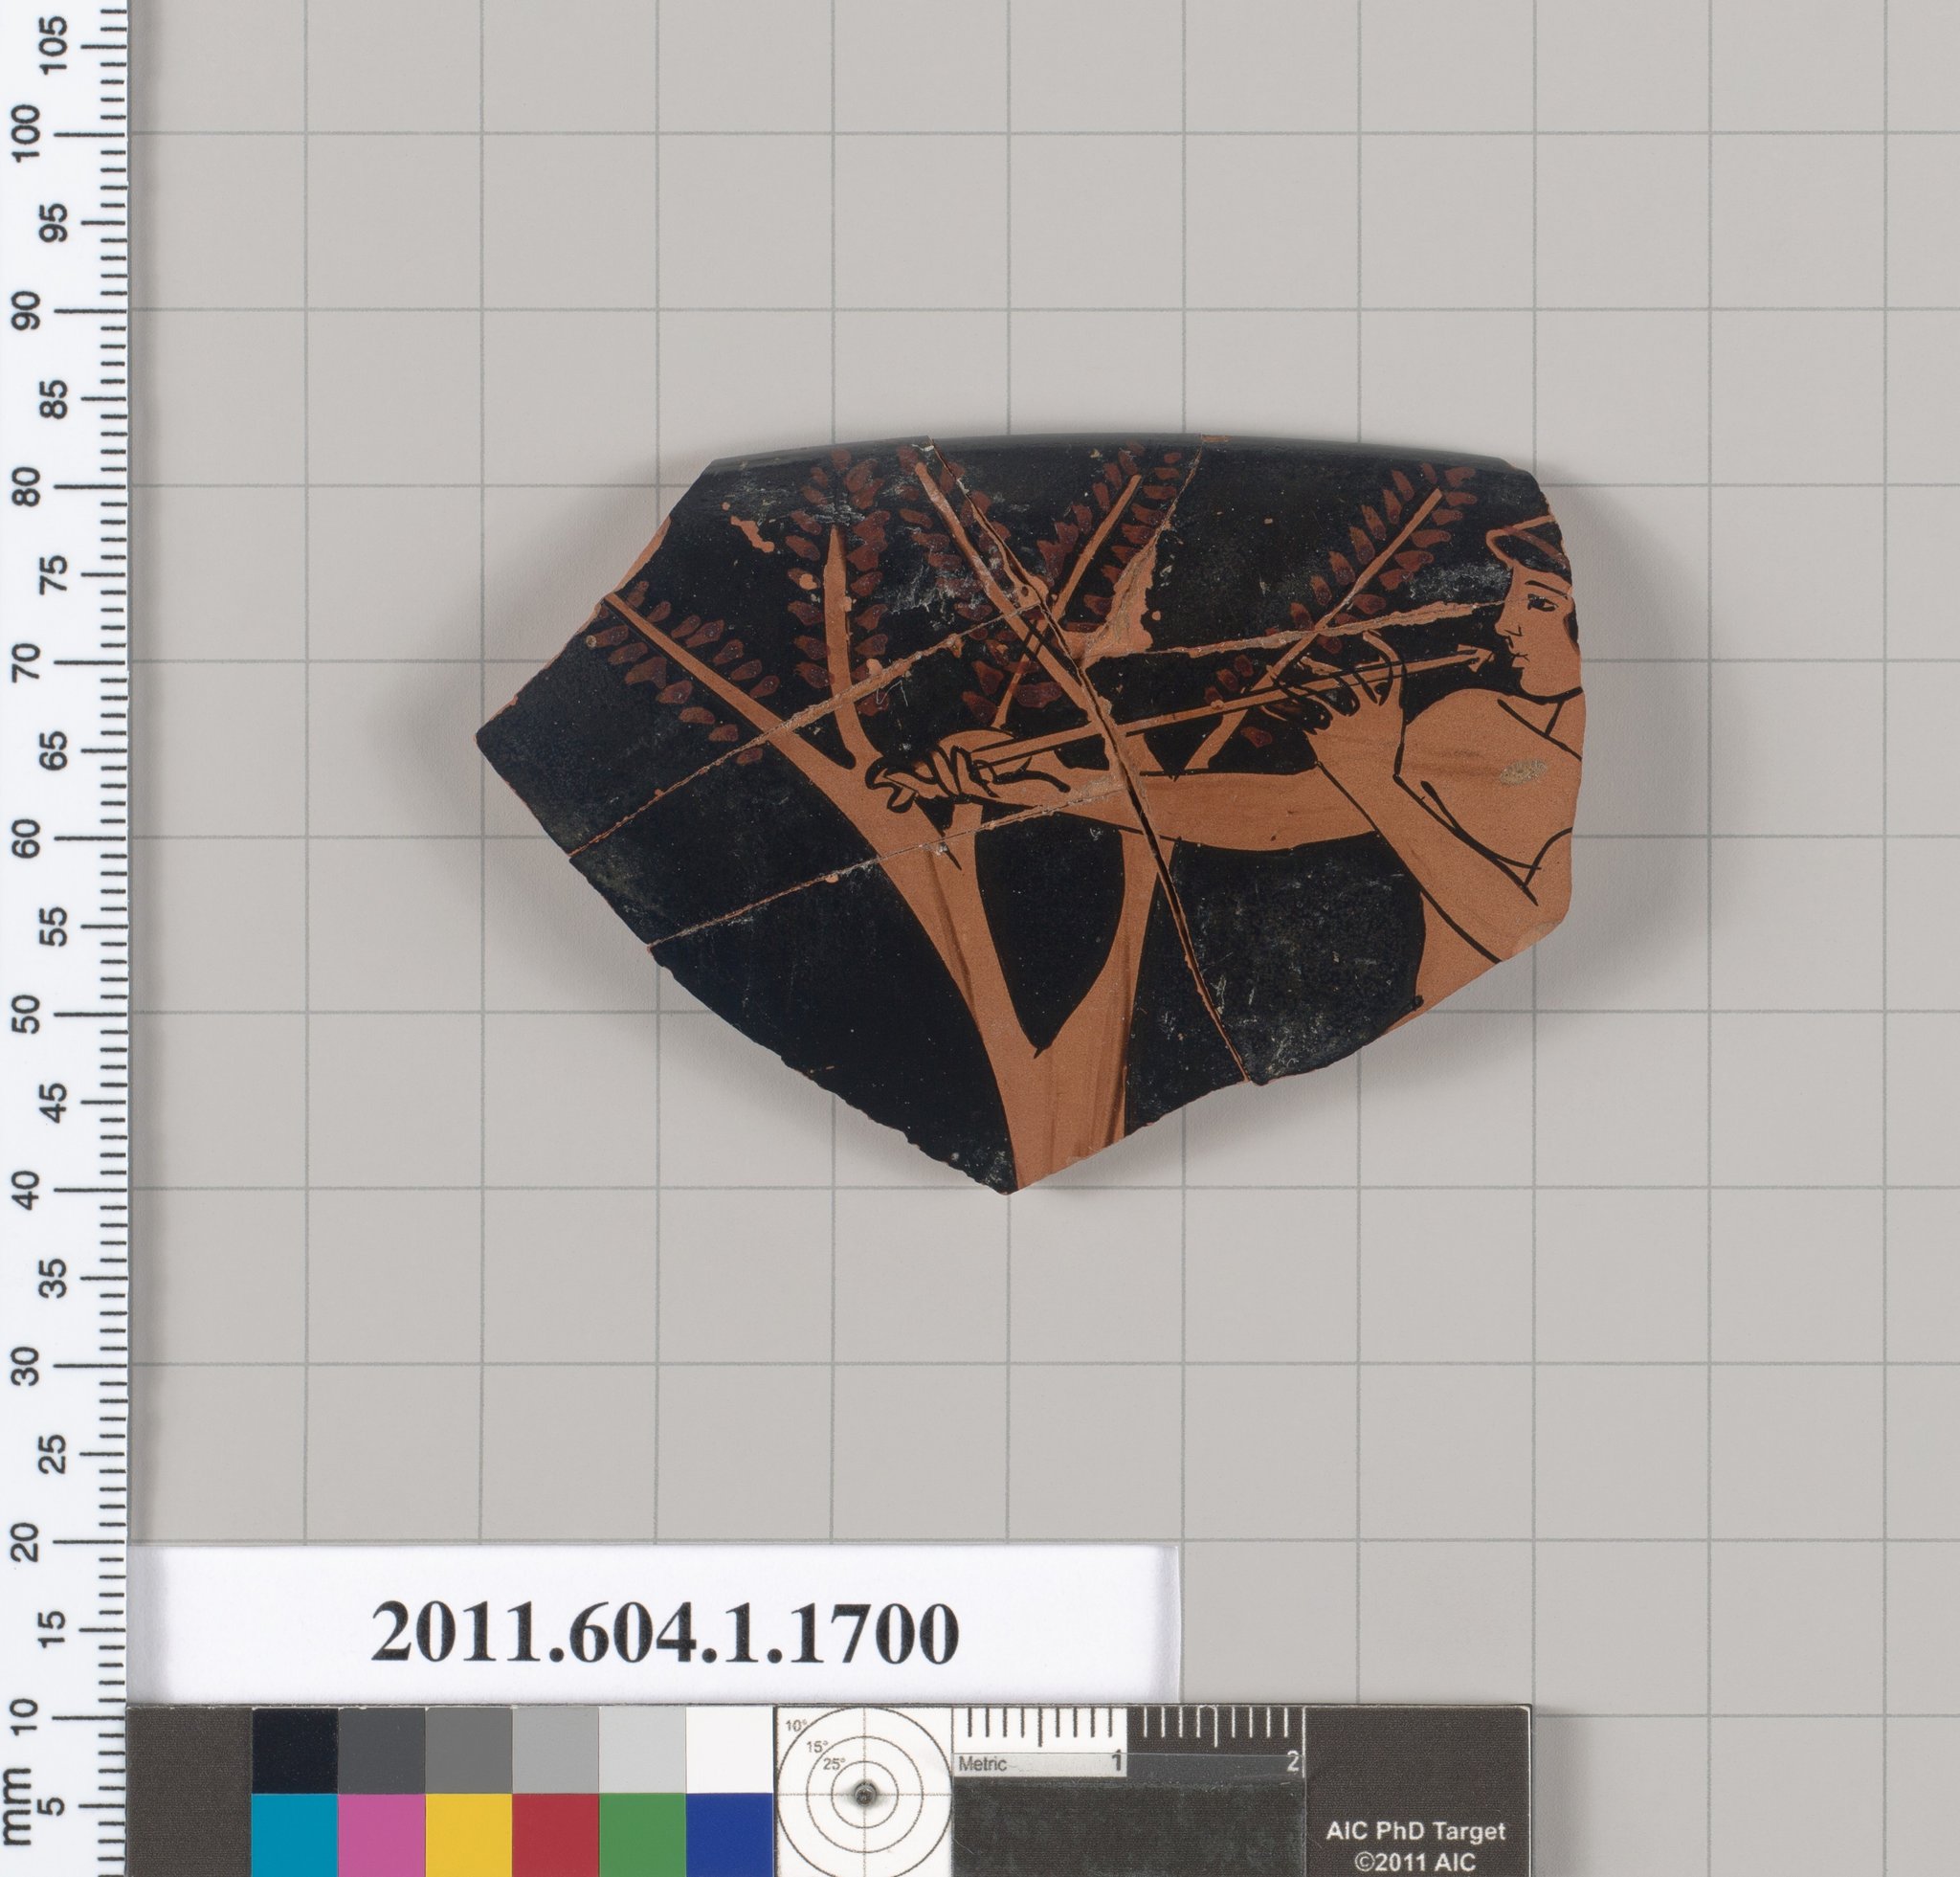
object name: kylix fragment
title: Terracotta rim fragment of a kylix (drinking cup)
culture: greek, attic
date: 490-480 BCE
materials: terracotta